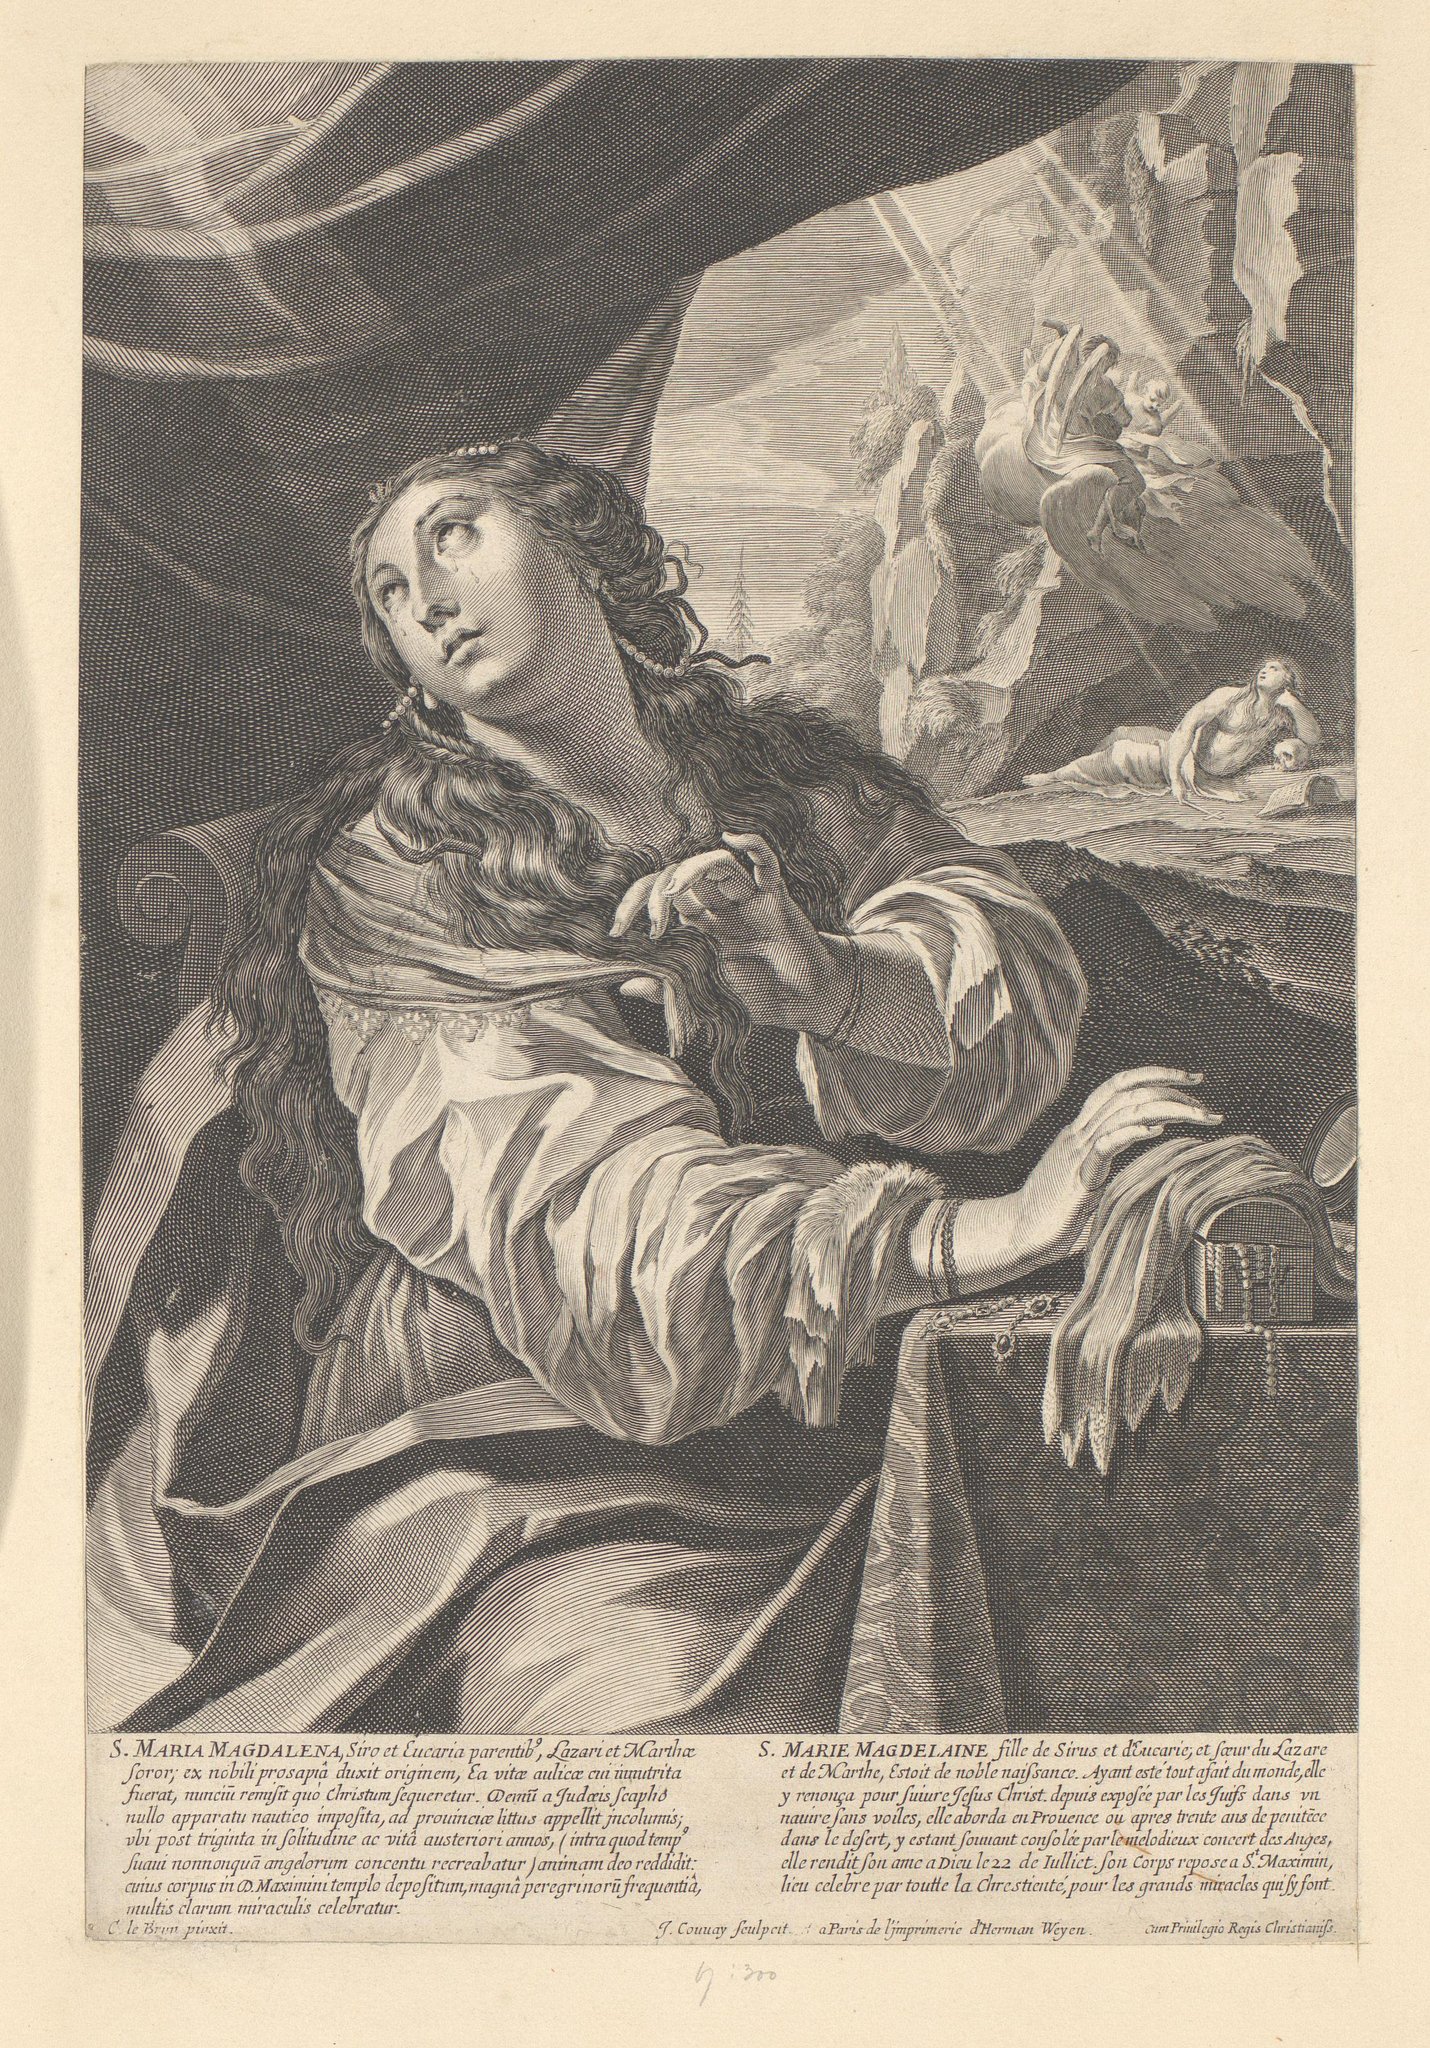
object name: album leaf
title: L'ouvrage de Charles le Brun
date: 1632-1675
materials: paper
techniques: engraving, etching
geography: paris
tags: the penitent harlot mary magdalene; possible attributes: book (or scroll), crown, crown of thorns, crucifix, jar of ointment, mirror, musical instrument, palm-branch, rosary, scourge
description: Deze prent maakt deel uit van een album.